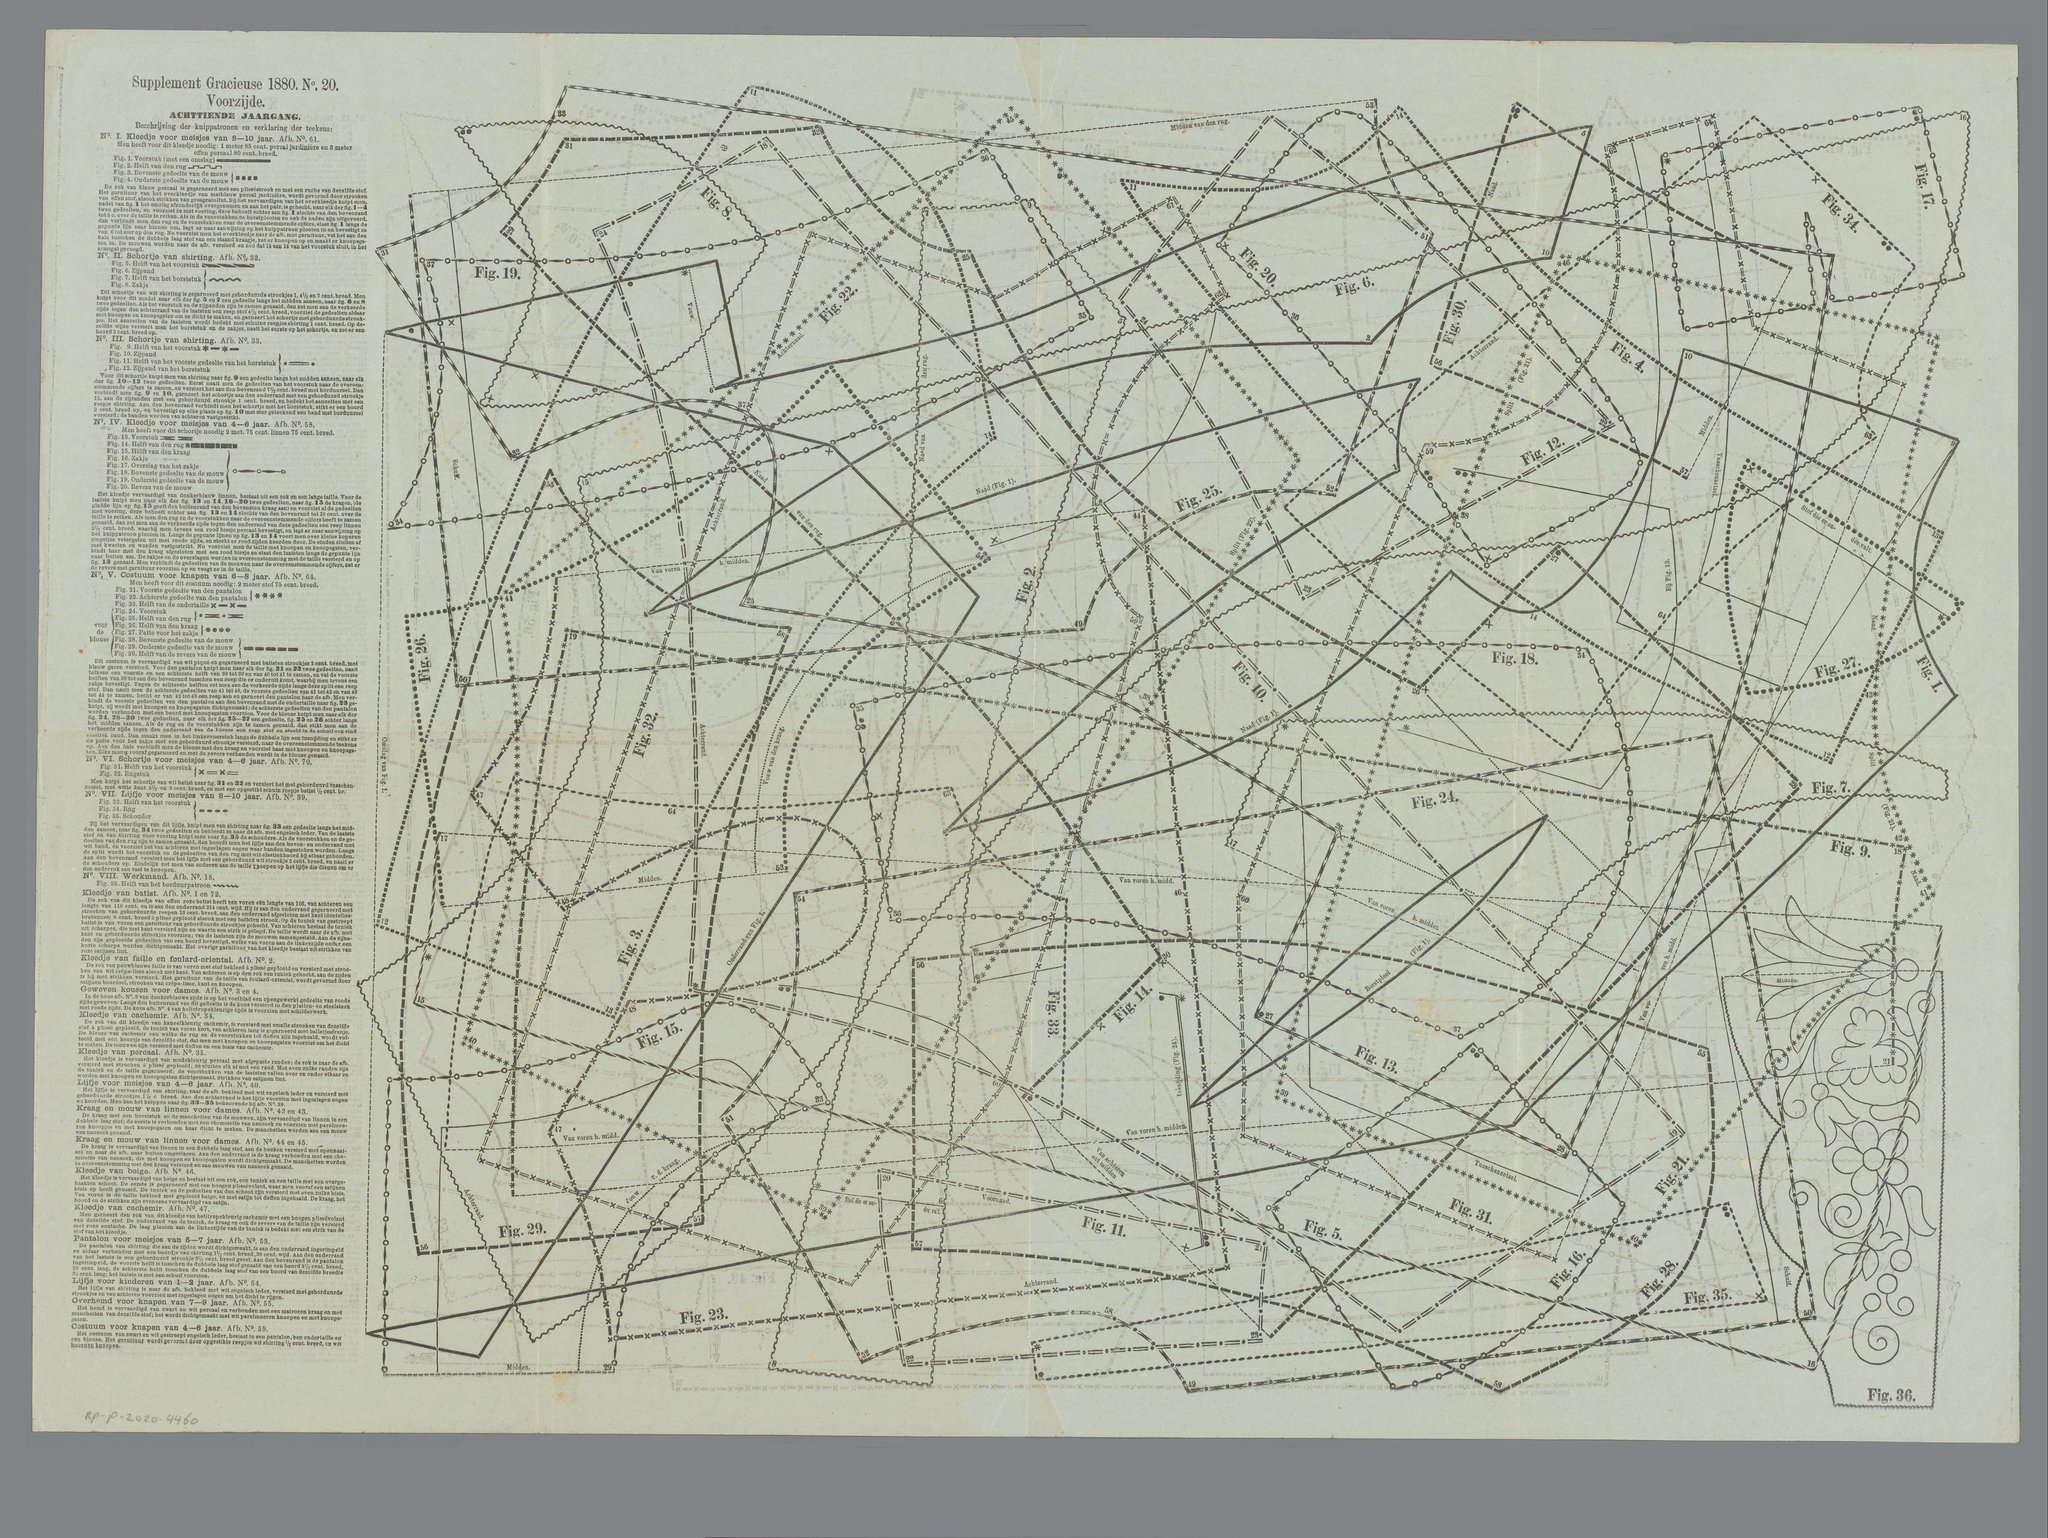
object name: photomechanical print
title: Knippatronen voor dames- en kinderkleding, 1880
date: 1880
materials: paper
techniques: letterpress printing, line block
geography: netherlands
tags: textile industry and clothing industry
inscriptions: date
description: Bijvoegsel bij: Gracieuse. Geïllustreerde Aglaja 18 (1880), nr. 20, 15 augustus 1880.